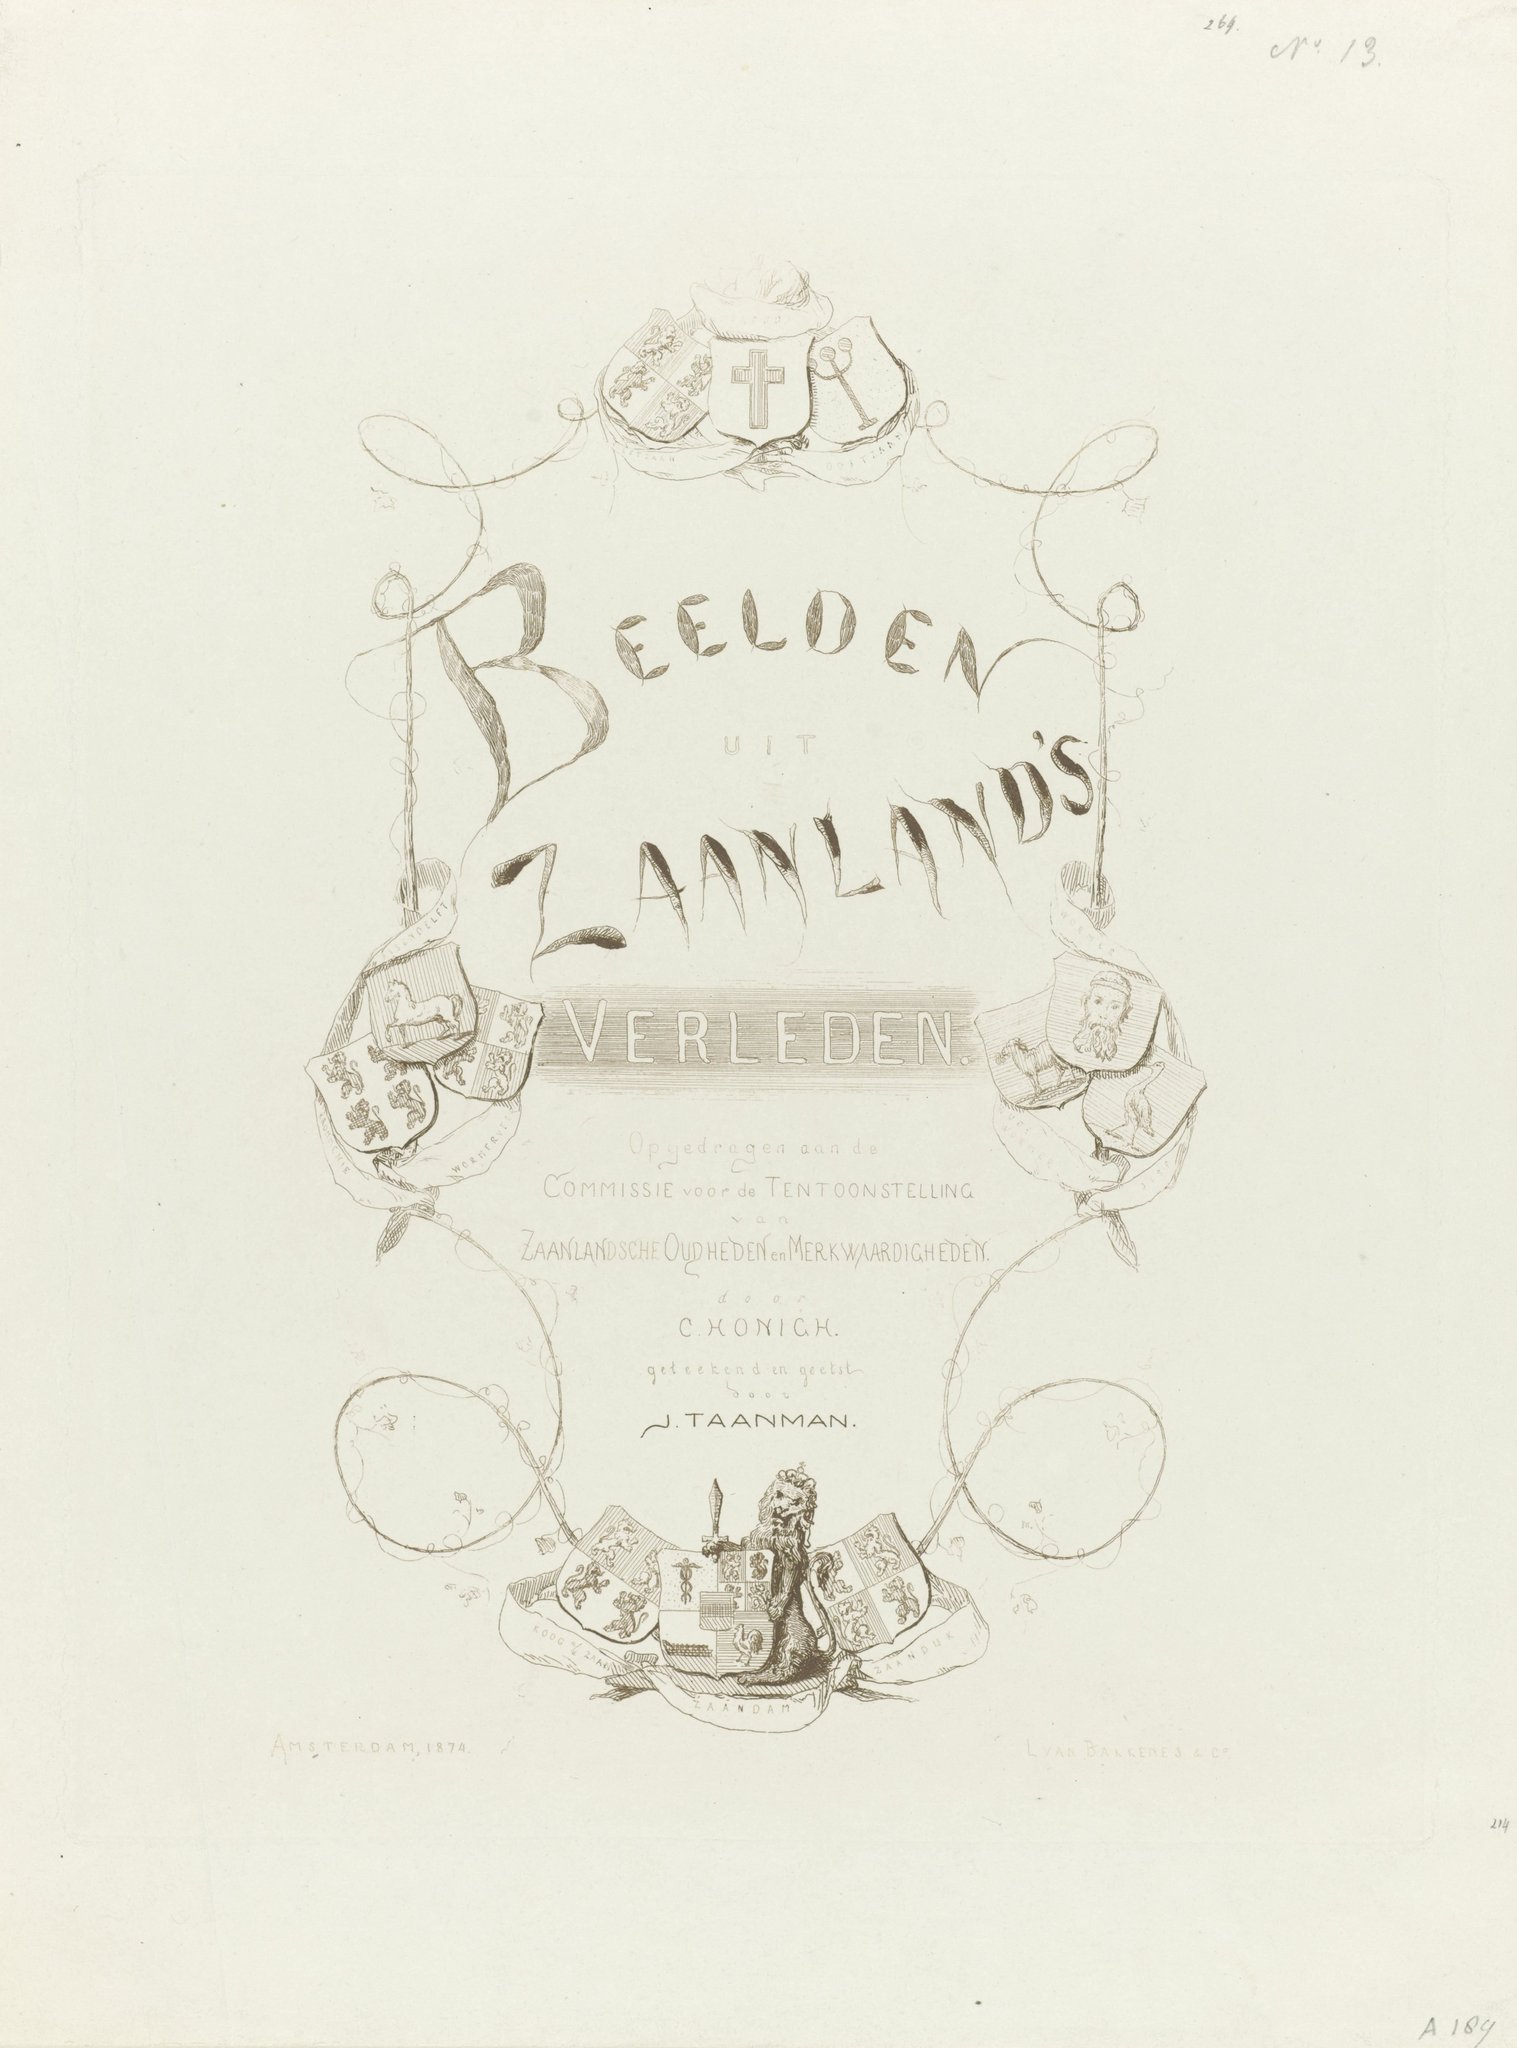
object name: titelblad, titelpagina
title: Titelpagina voor: C. Honigh, Beelden uit Zaanland's verleden, 1874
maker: jacob taanman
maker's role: draughtsman, print maker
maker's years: 1836-1923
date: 1874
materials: paper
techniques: etching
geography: amsterdam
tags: armorial bearing, heraldry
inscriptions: date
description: Titelpagina voor het nooit verschenen Beelden uit Zaanland's verleden. Randwerk met de wapenschilden van dorpen en steden in de Zaanstreek. Bovenaan de wapenschilden van Westzaan en Oostzaan. Links: Assendelft, Krommenie en Wormerveer. Rechts: Wormer, Wijde Wormer en Jisp. Onderaan de wapenschilden van Koog aan de Zaan, Zaandam en Zaandijk.